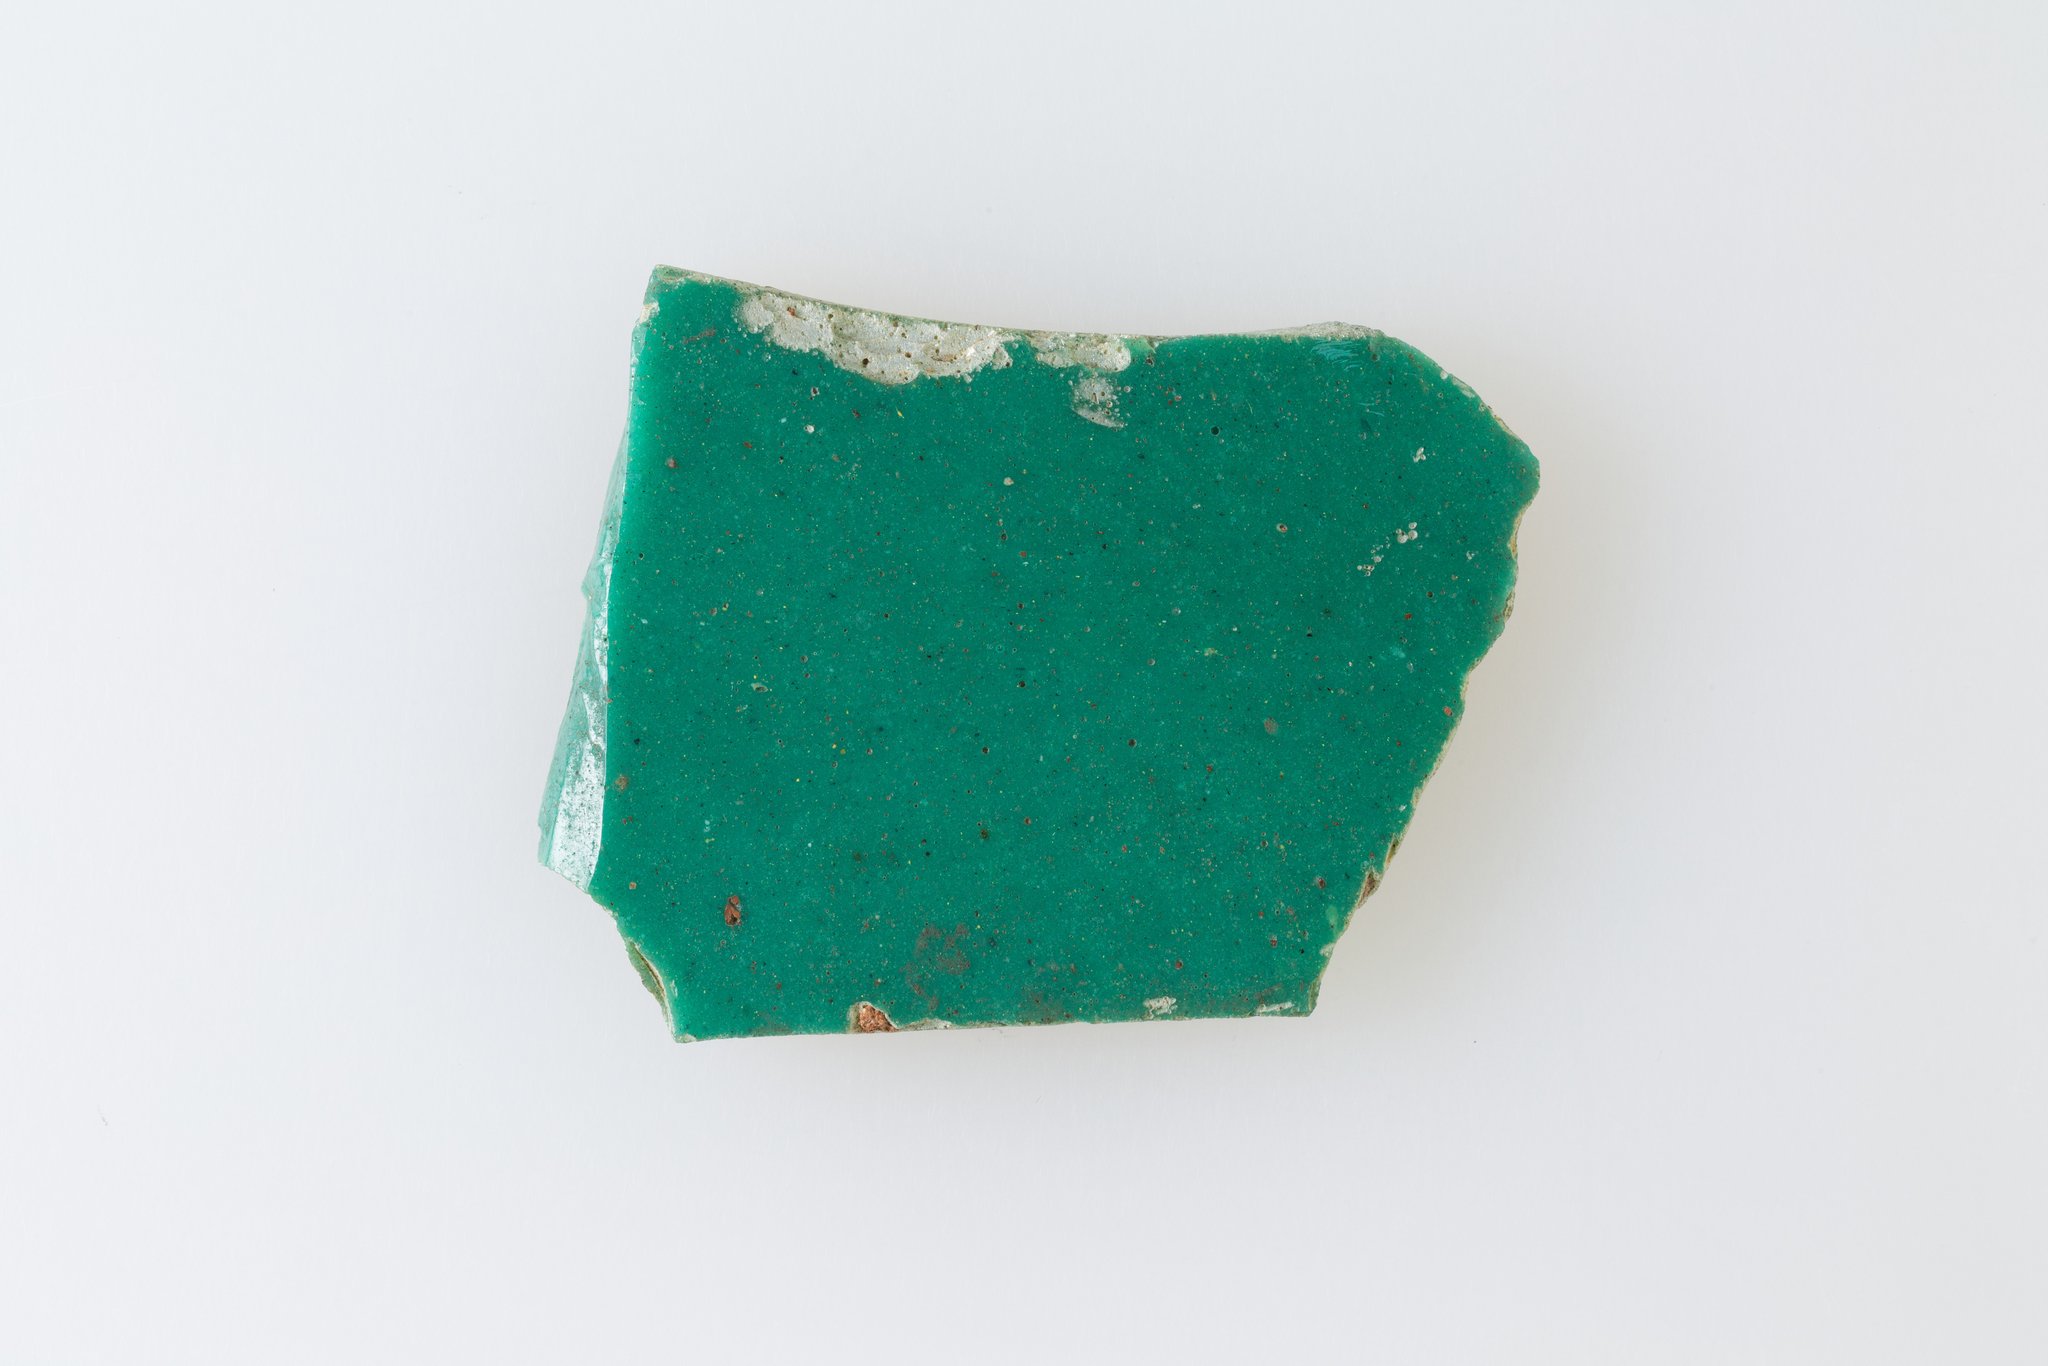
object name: wall revetment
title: Wall revetment, marble pattern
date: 200 BCE-100 CE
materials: glass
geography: egypt